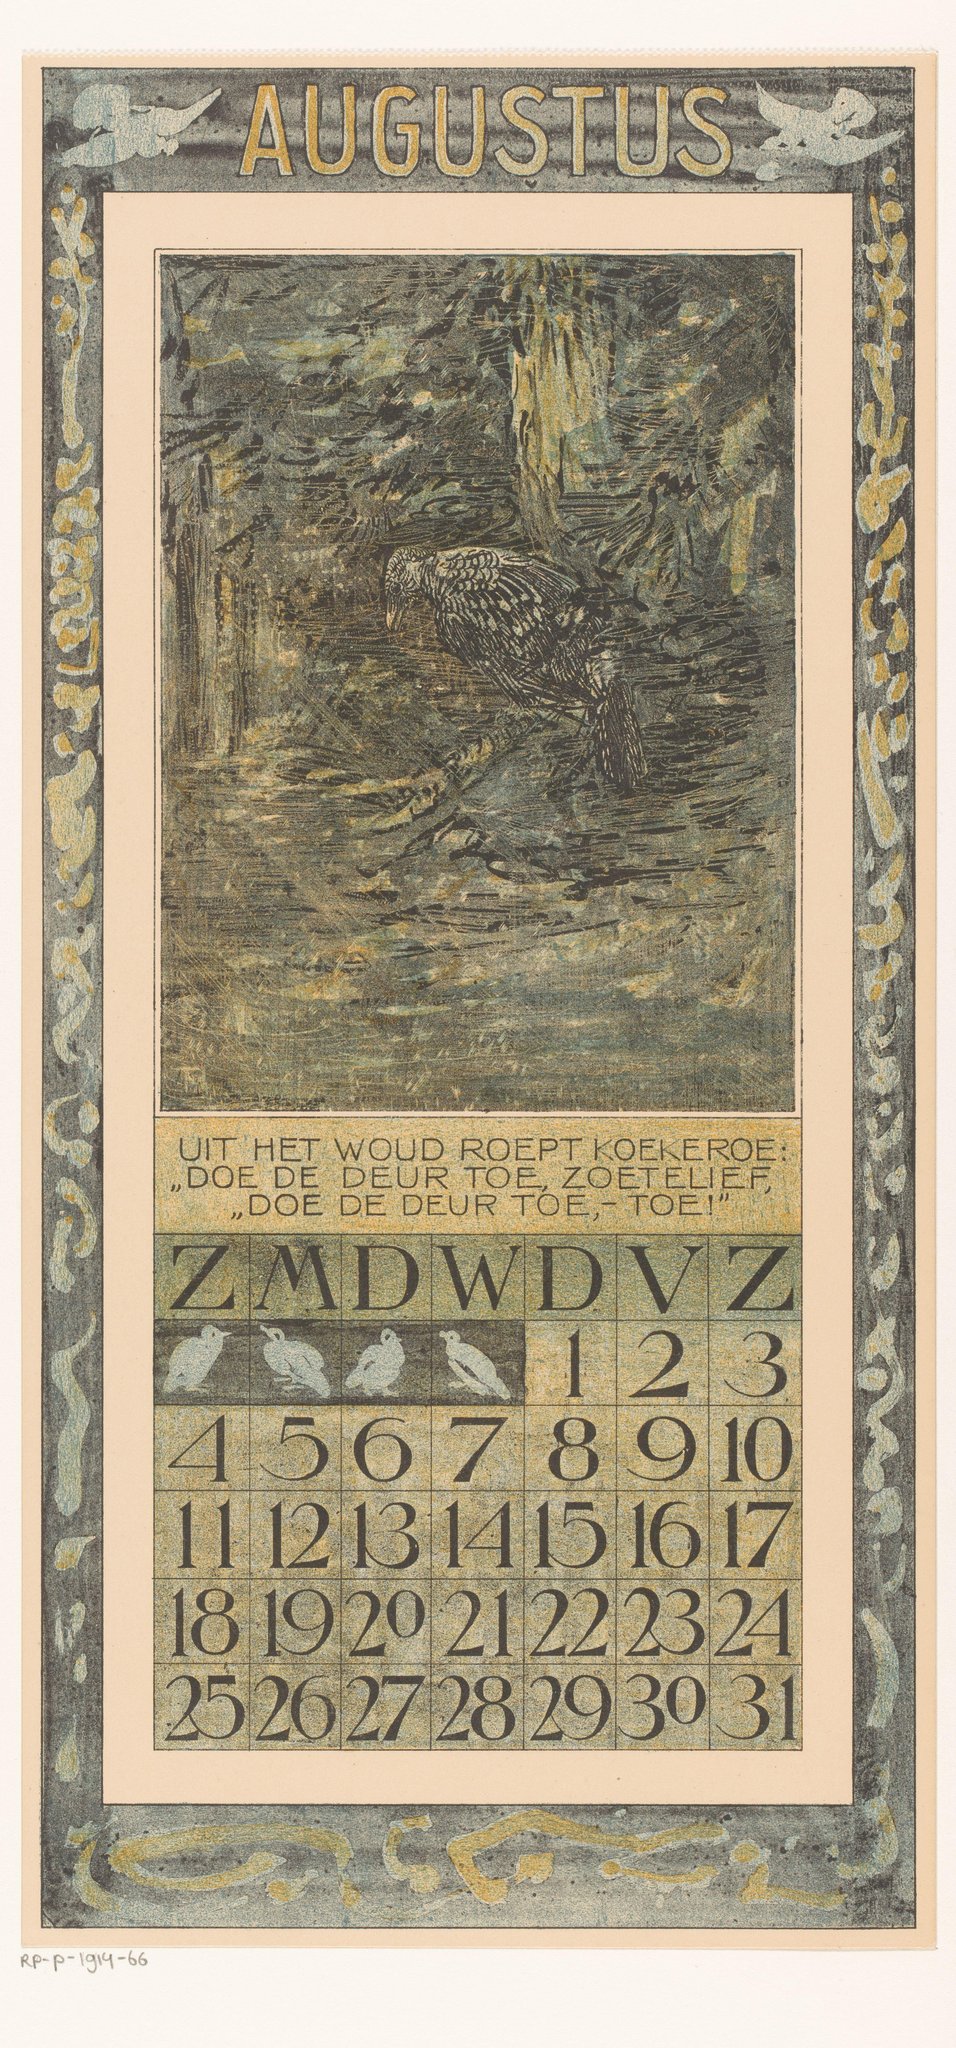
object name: calendar leaf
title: Kalender 1907 12 lithografien door Th. v. Hoytema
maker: theo van hoytema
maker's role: draughtsman, painter, print maker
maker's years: 1863-1917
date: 1906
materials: paper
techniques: lithograph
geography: amsterdam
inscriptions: collector's mark: Lugt 2228